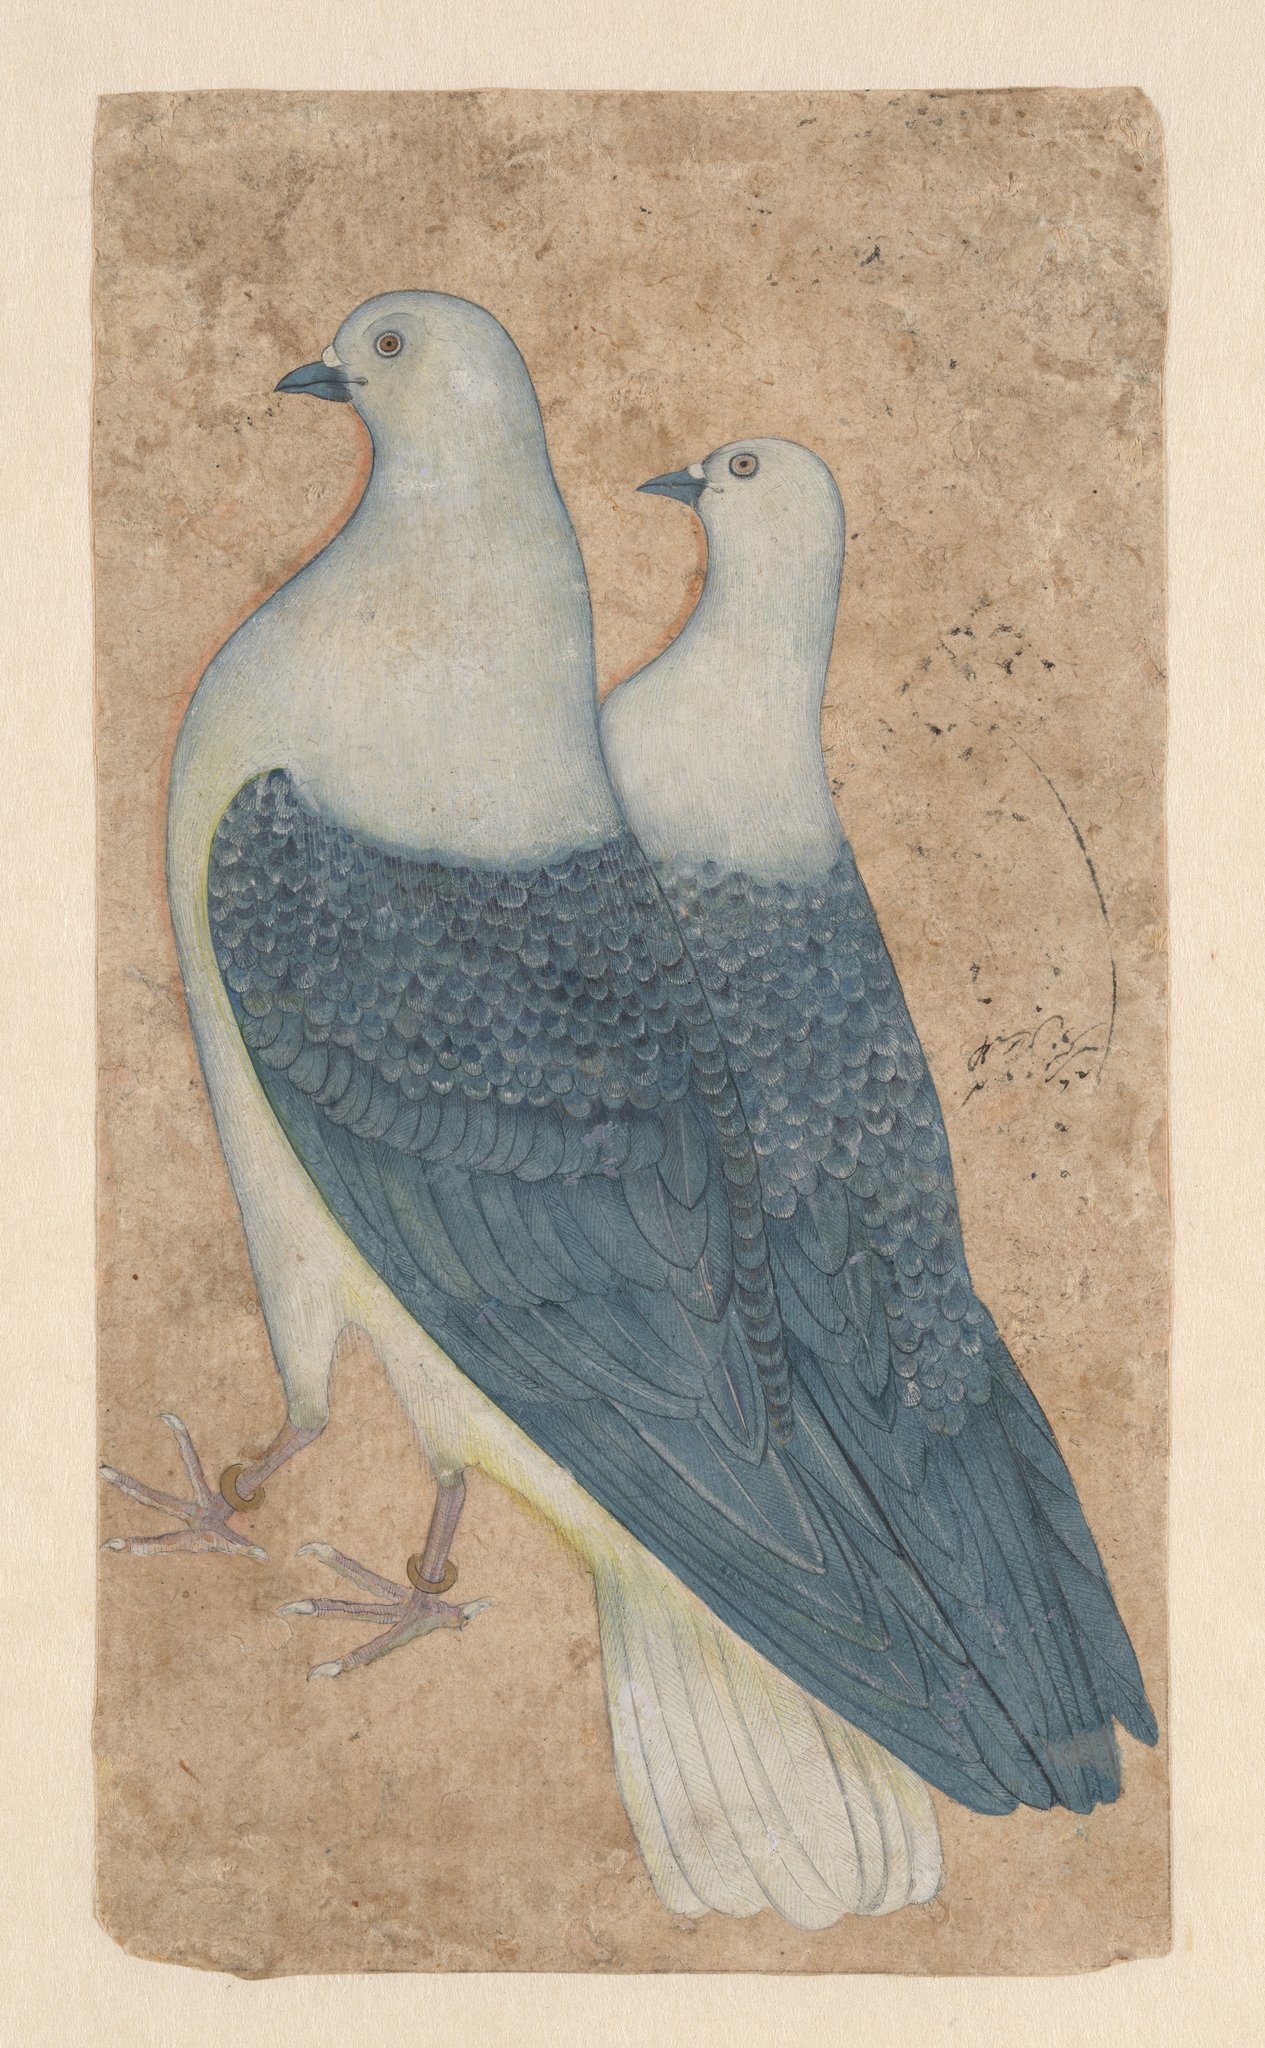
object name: illustrated single work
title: Two Pigeons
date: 1650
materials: paper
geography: india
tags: birds